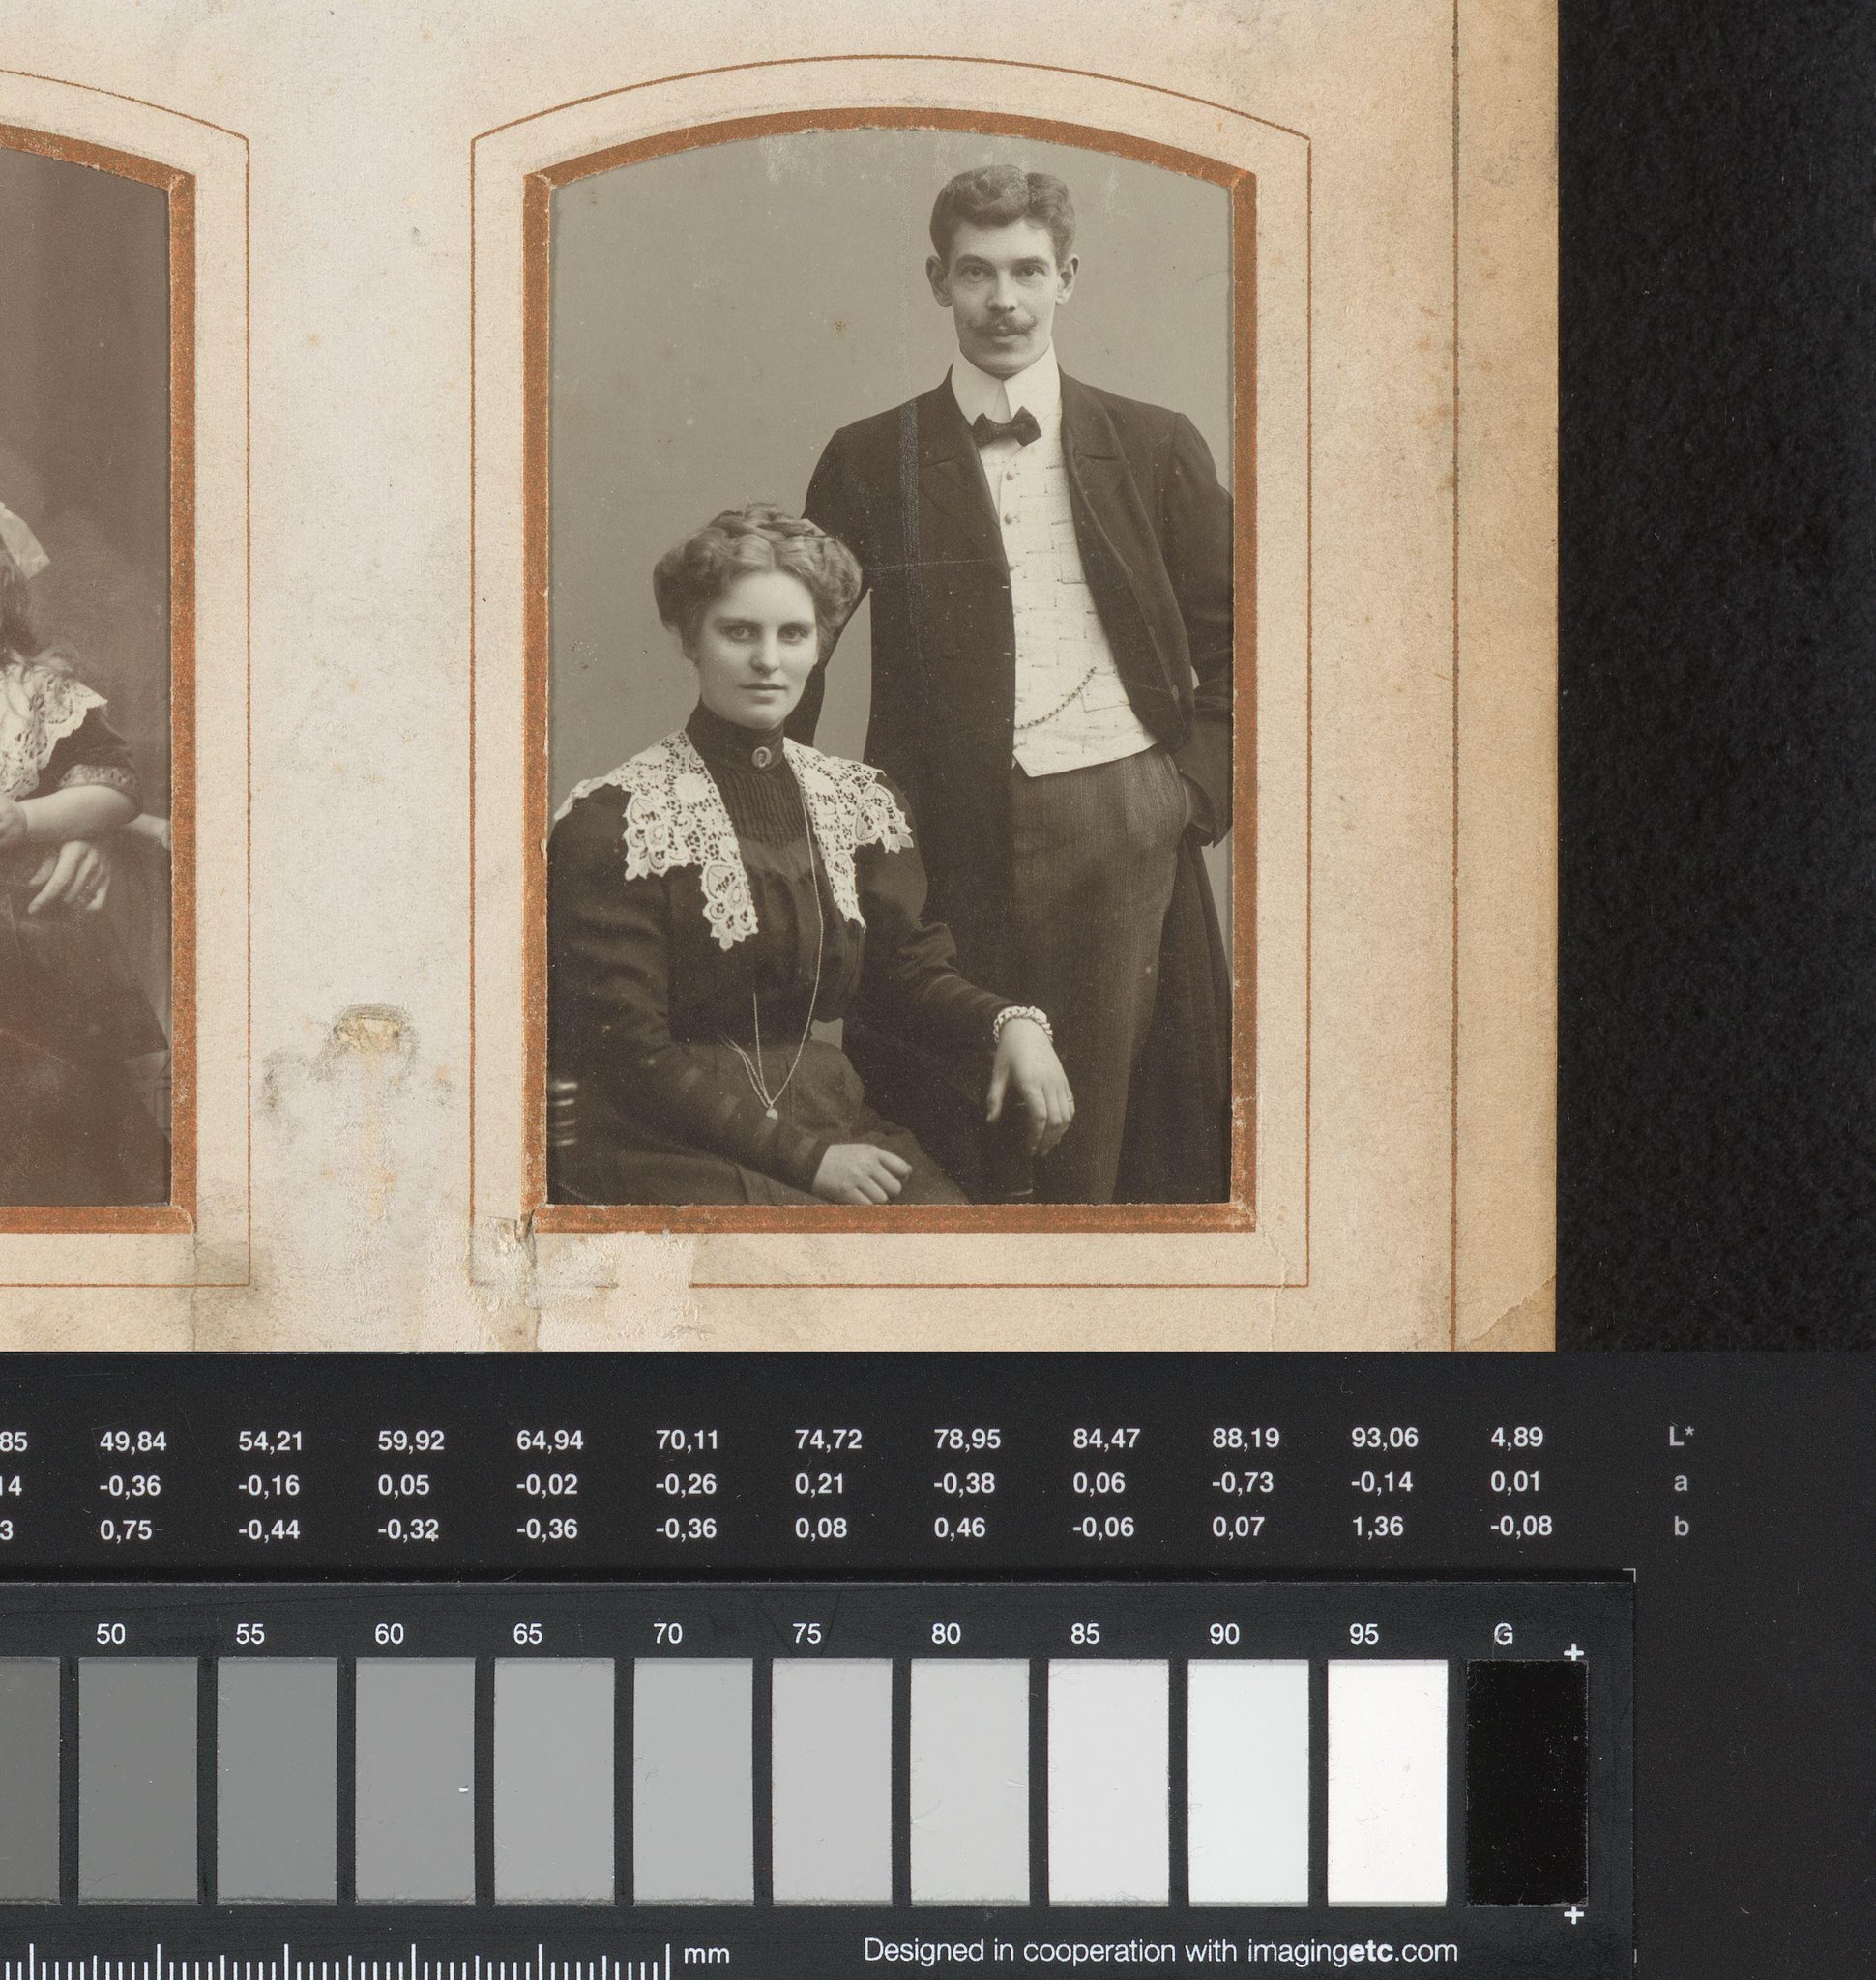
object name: album leaf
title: Portret van een zittende vrouw en een staande man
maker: sandels j:or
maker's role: fotograaf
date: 1895-1920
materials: cardboard, photographic support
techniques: matte daylight collodion silver print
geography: stockholm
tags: standing figure, historical persons - bb - woman, historical persons, toddler (female)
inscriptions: inscription: ‘93 29./ Fotograf Sandels J:or/ Stockholm/ Drottninggatan 27./ (...)’